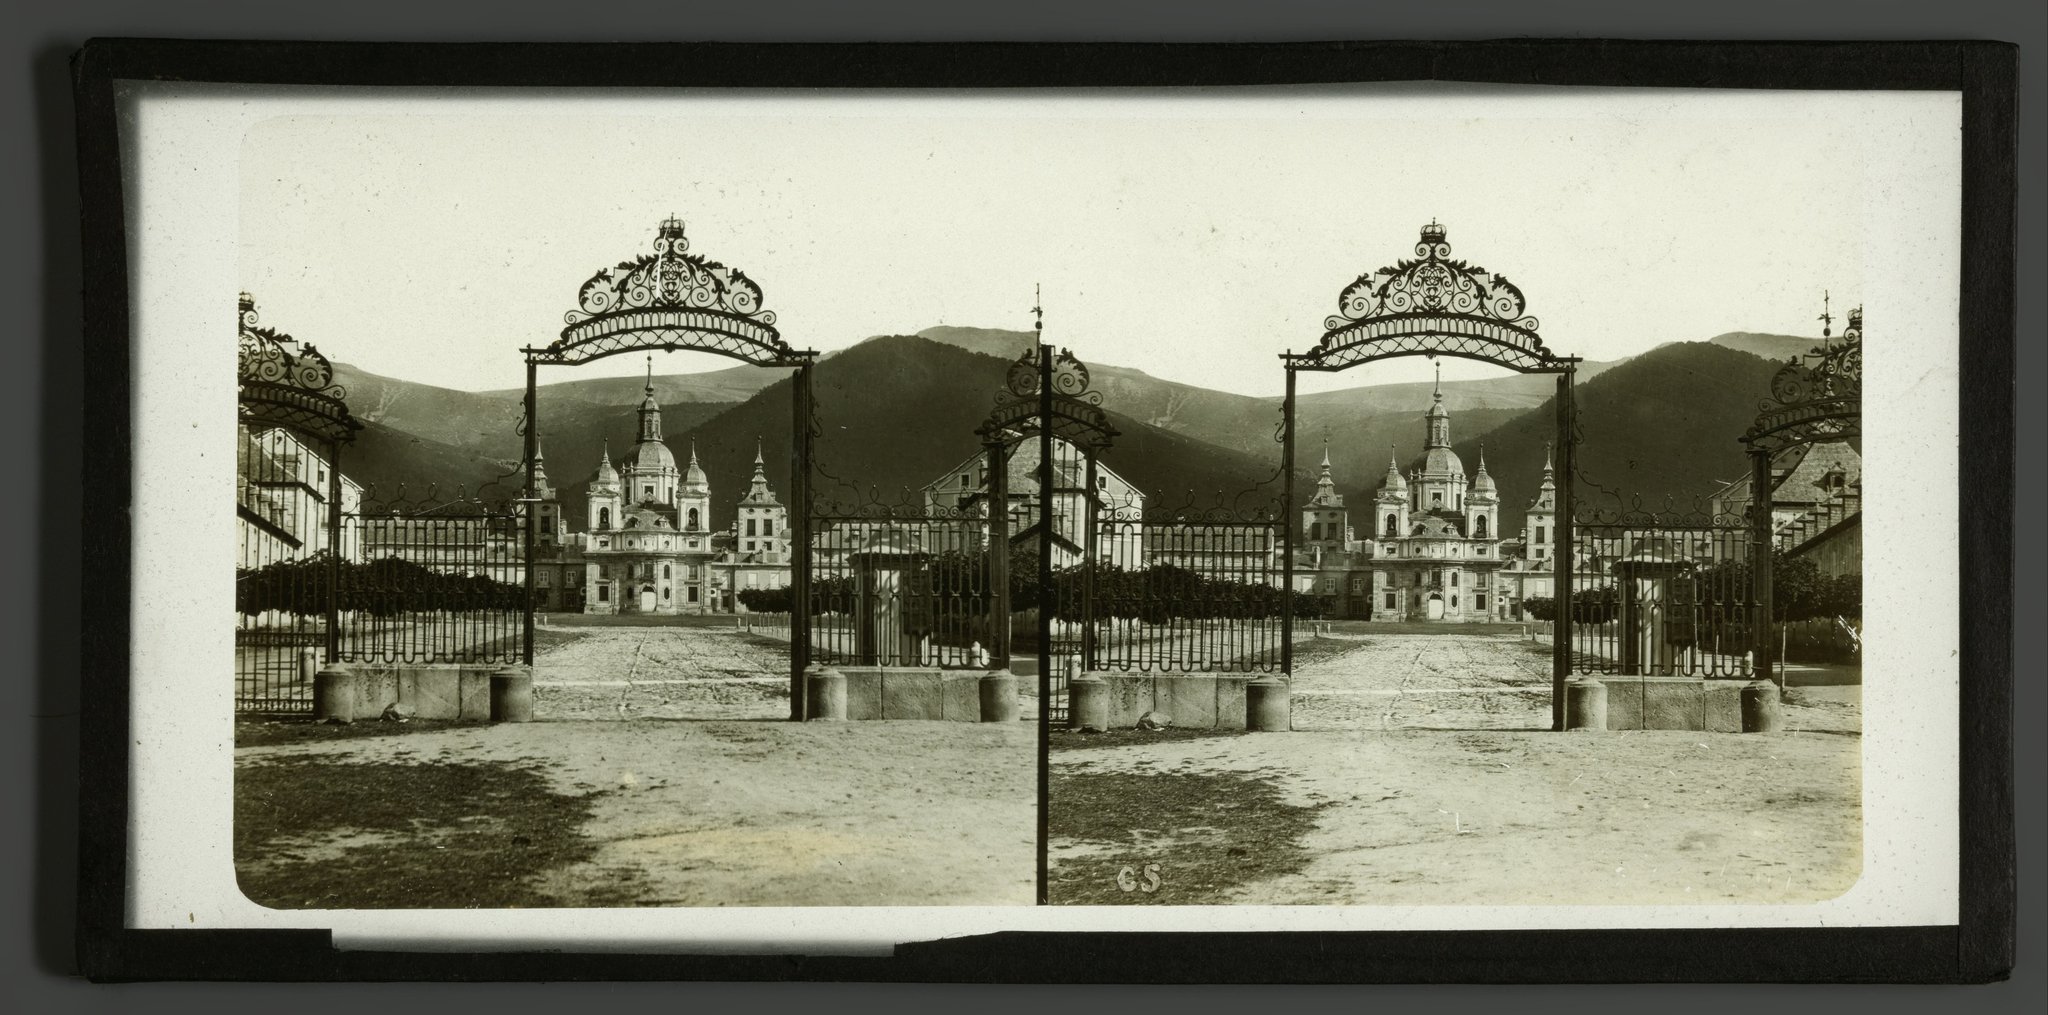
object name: photograph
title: Paleis in een berglandschap, mogelijk in Duitsland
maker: charles segoffin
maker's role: fotograaf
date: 1860-1890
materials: glass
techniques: slide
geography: germany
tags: palace, germany